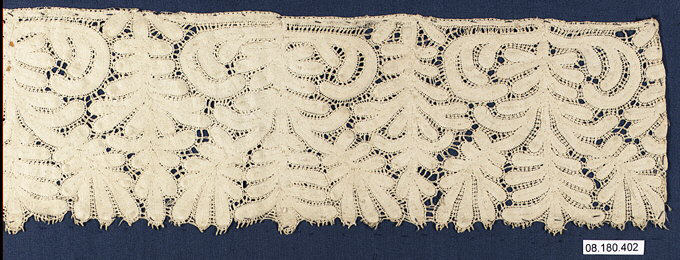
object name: piece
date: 1767-1800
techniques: lace